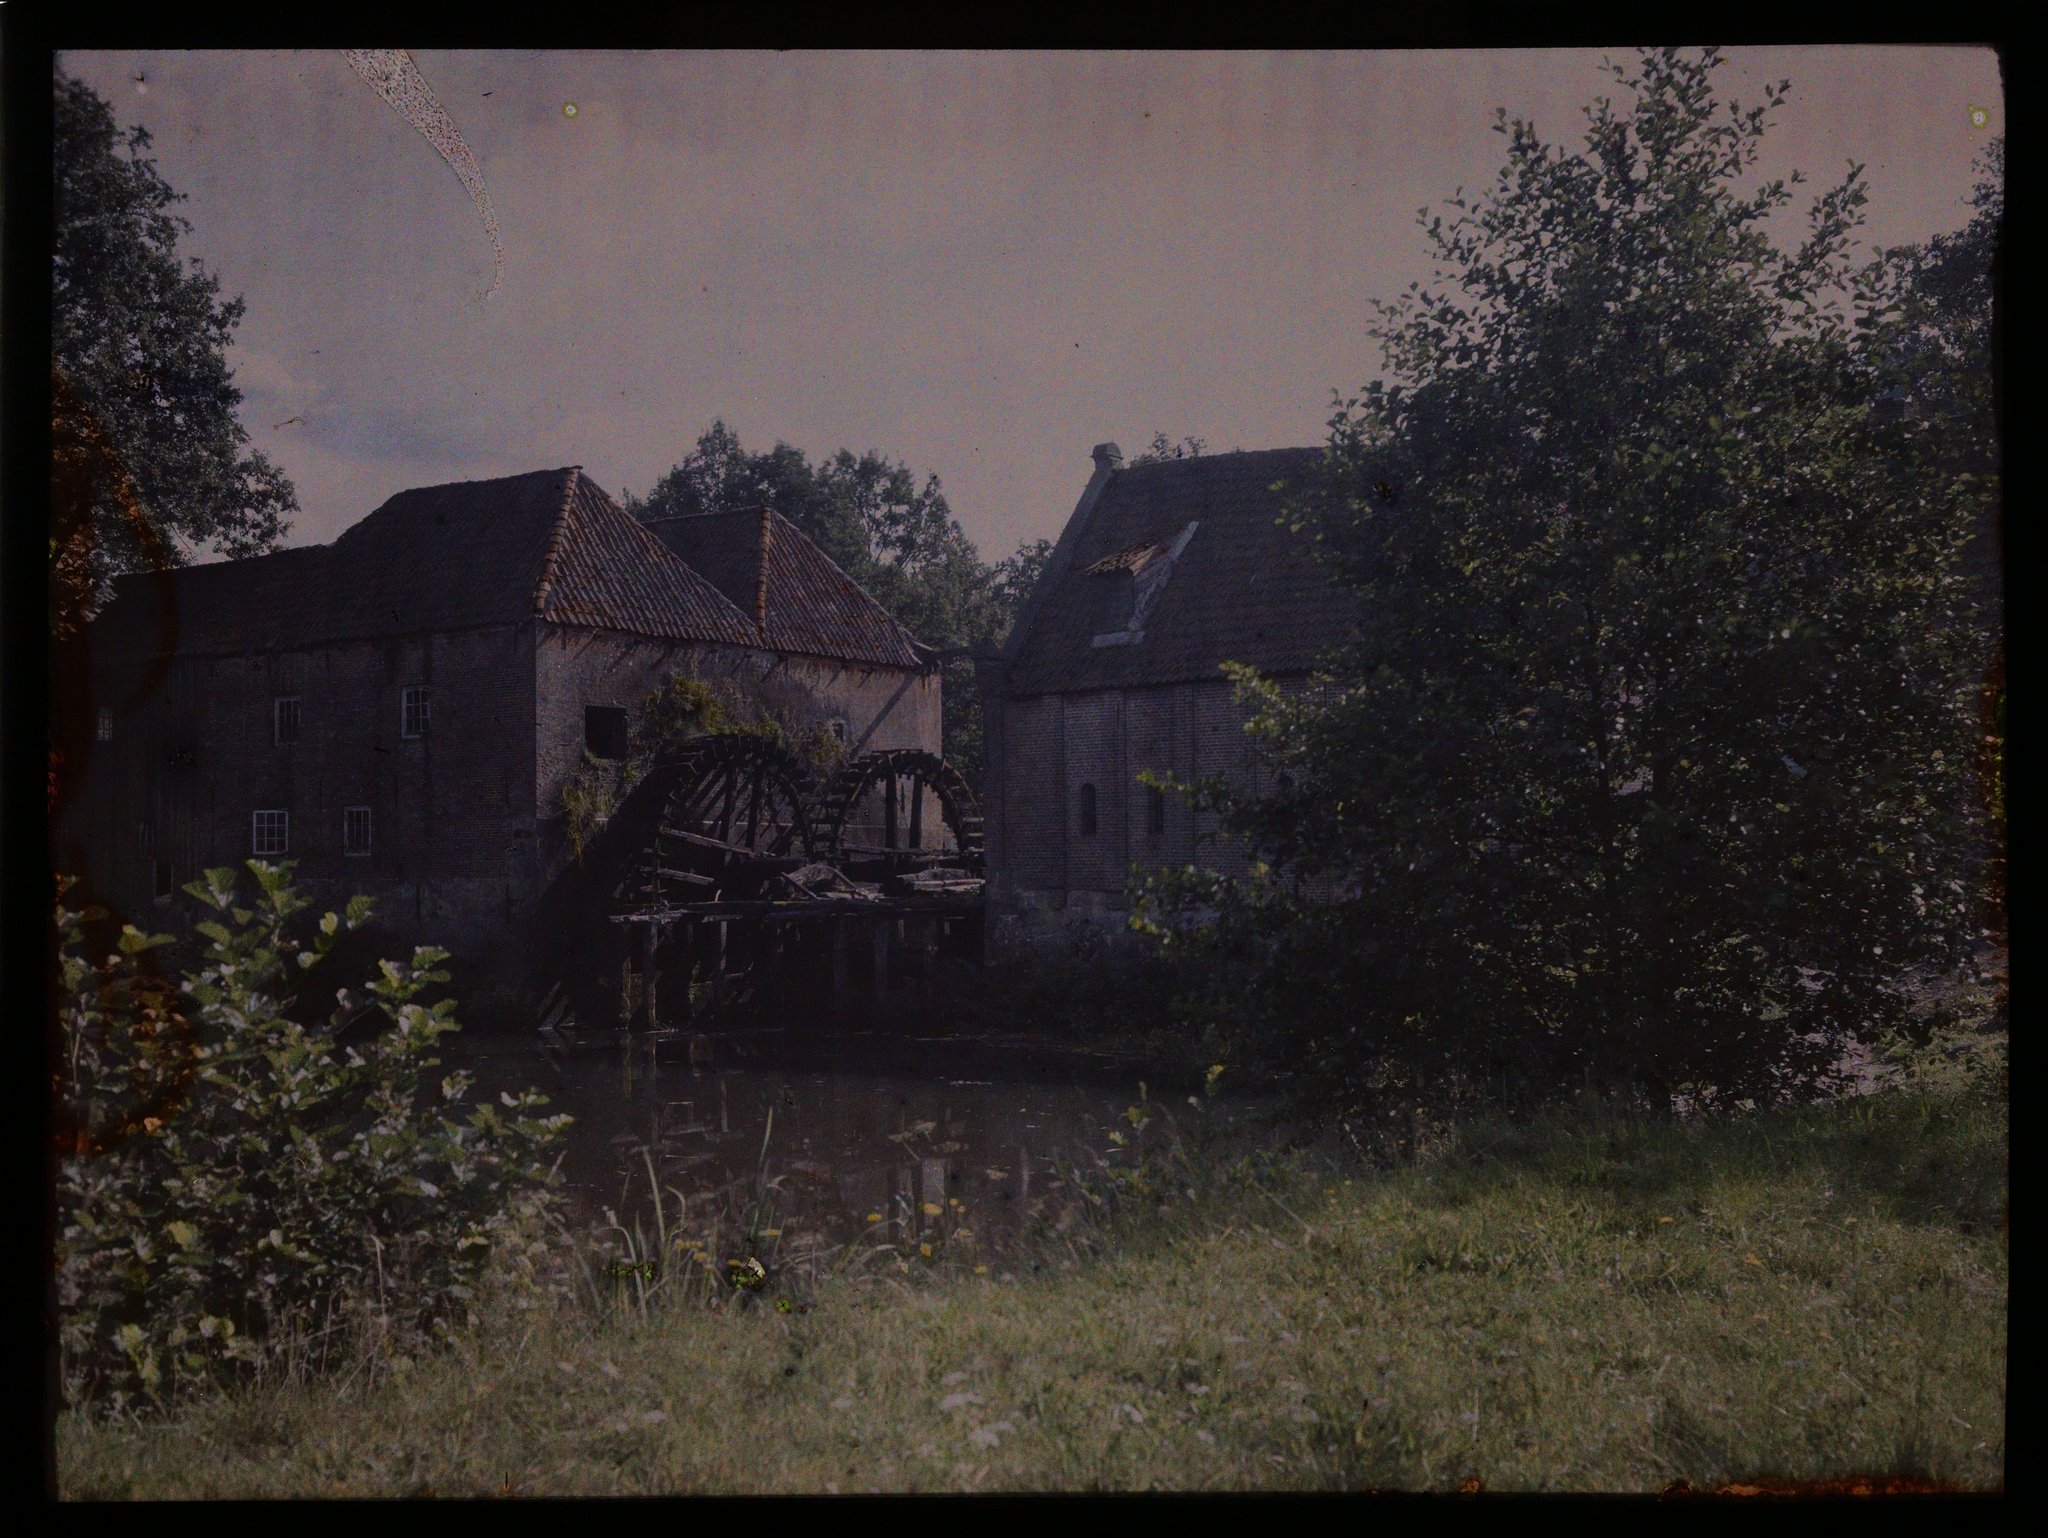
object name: photograph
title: Watermolen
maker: Anonymous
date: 1907-1935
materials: glass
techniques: autochrome process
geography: netherlands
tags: watermill, watermill in landscape, netherlands